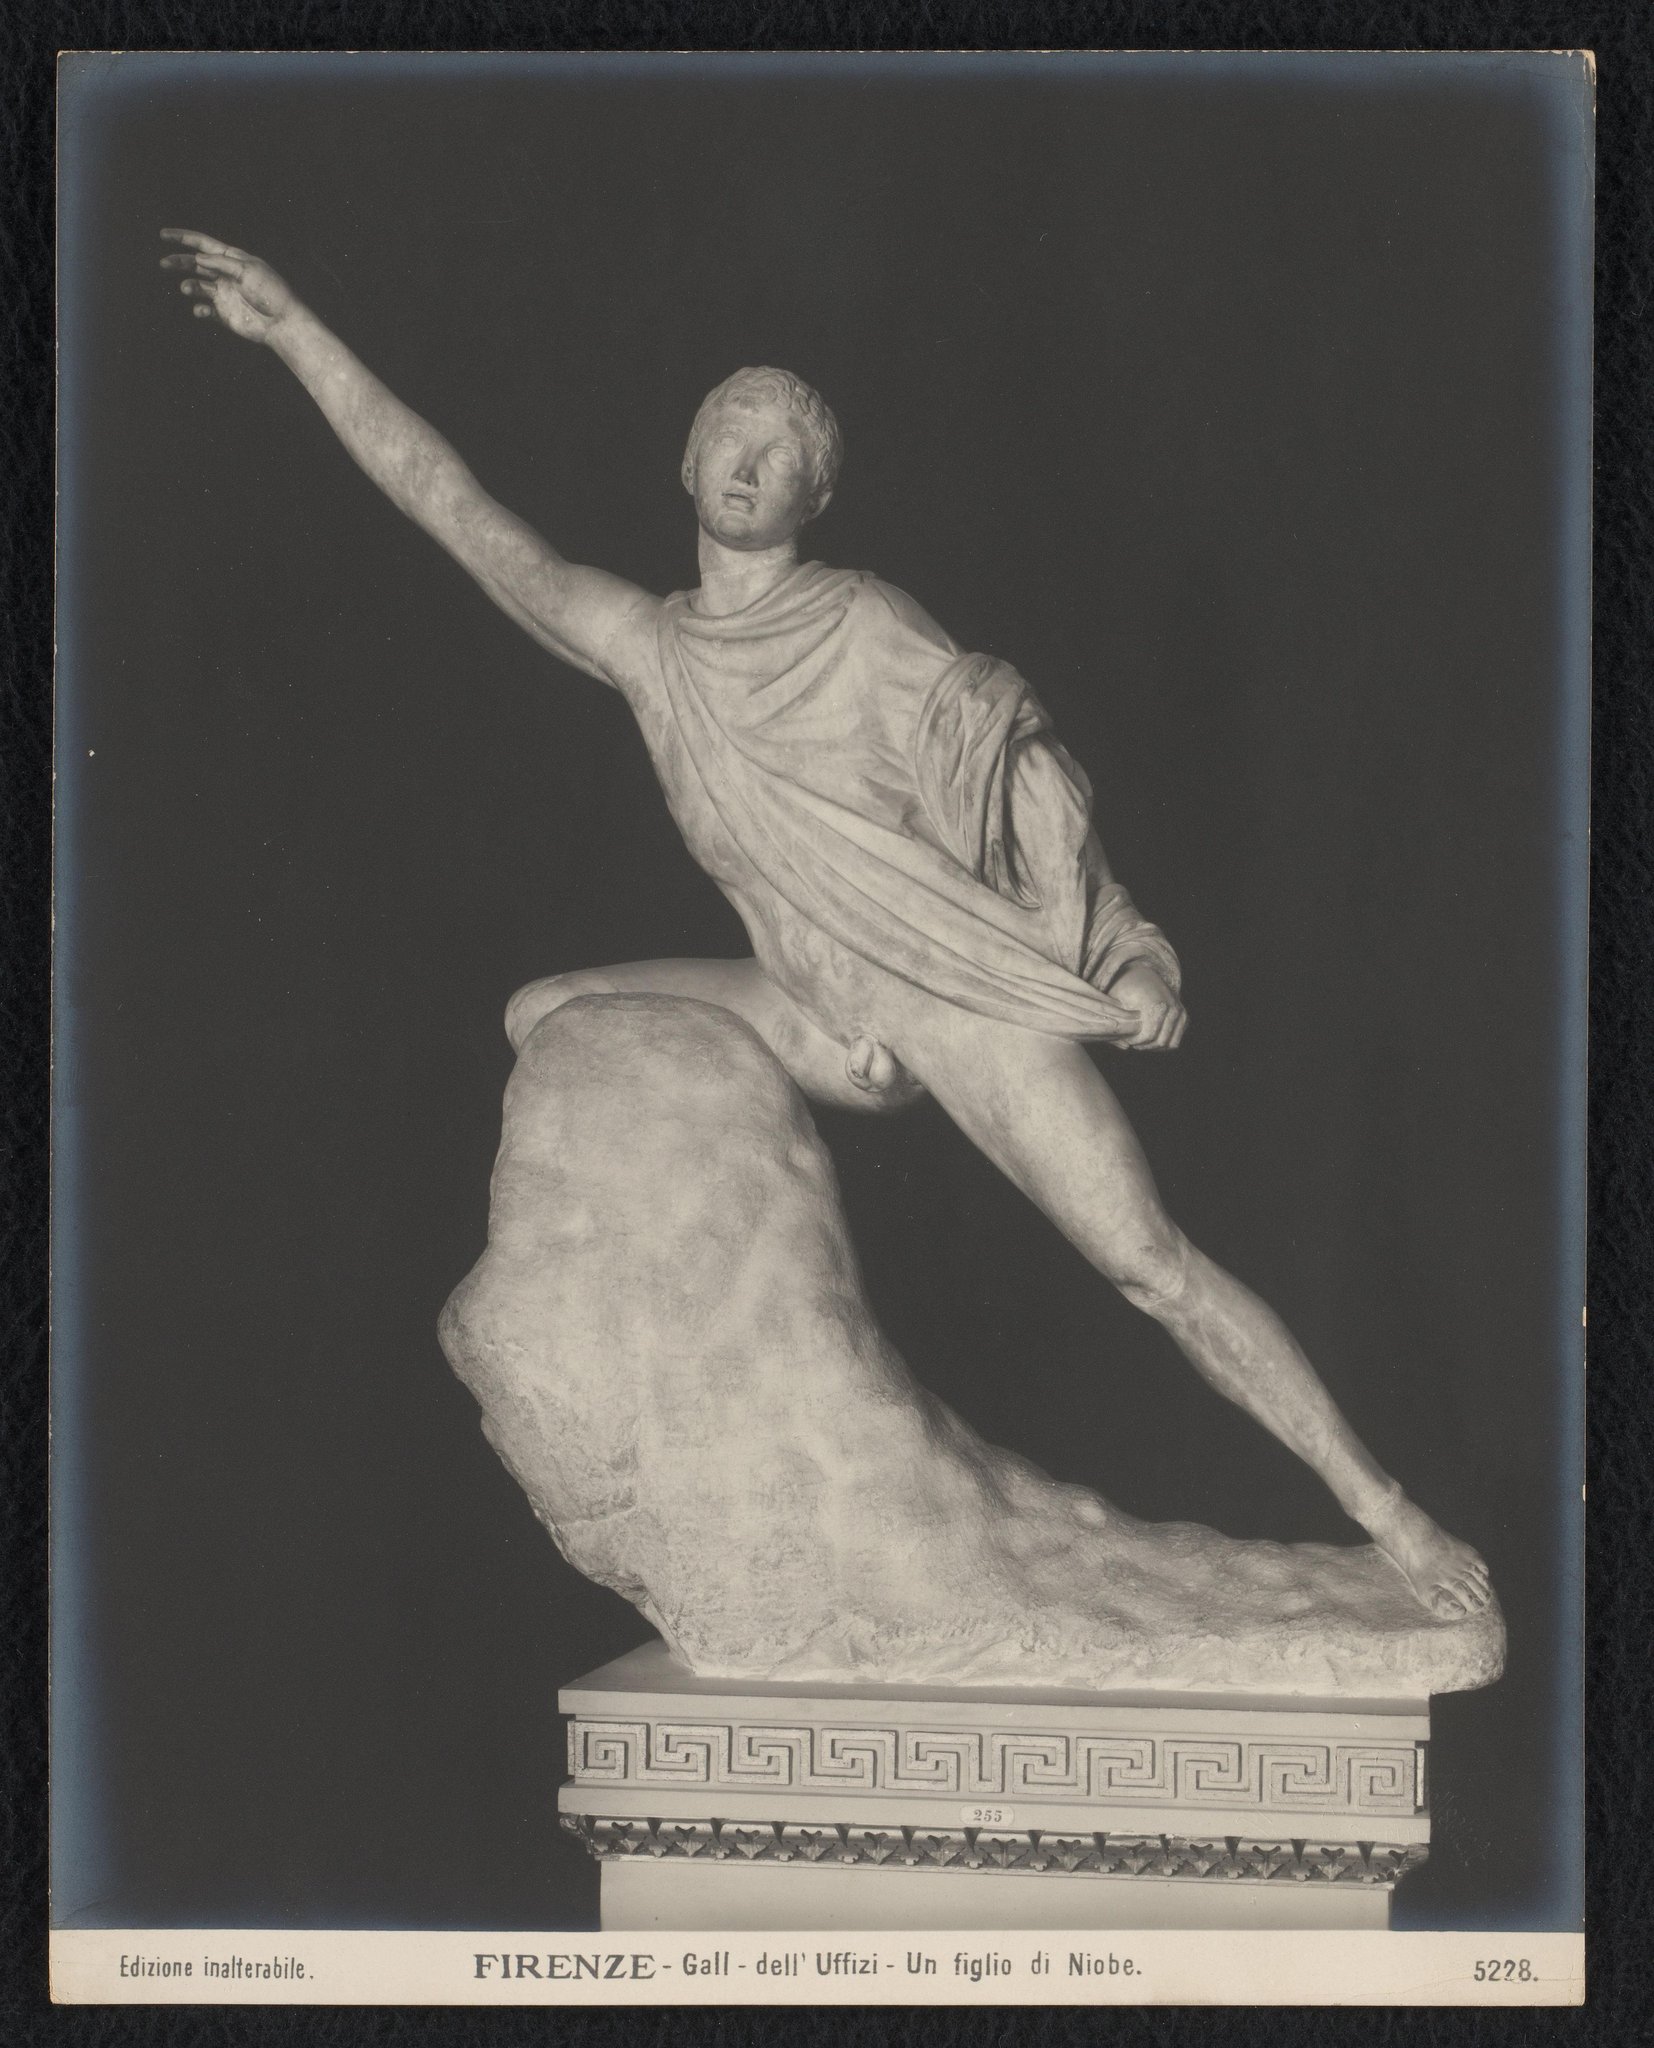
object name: photograph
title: Gall - dell'Uffizi - Un figlio di Niobe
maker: Anonymous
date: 1901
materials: paper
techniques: gelatin silver print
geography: florence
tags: (story of) bacchus (dionysus), liber, piece of sculpture, reproduction of a piece of sculpture, (story of) niobe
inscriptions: number: ‘5228.’, collector's mark: ‘RIJKS SCHOOL VOOR KUNSTNIJVERHEID/ GROEP’, inscription: ‘Edizione inalterabile.’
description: Deze foto maakt deel uit van een omslag.